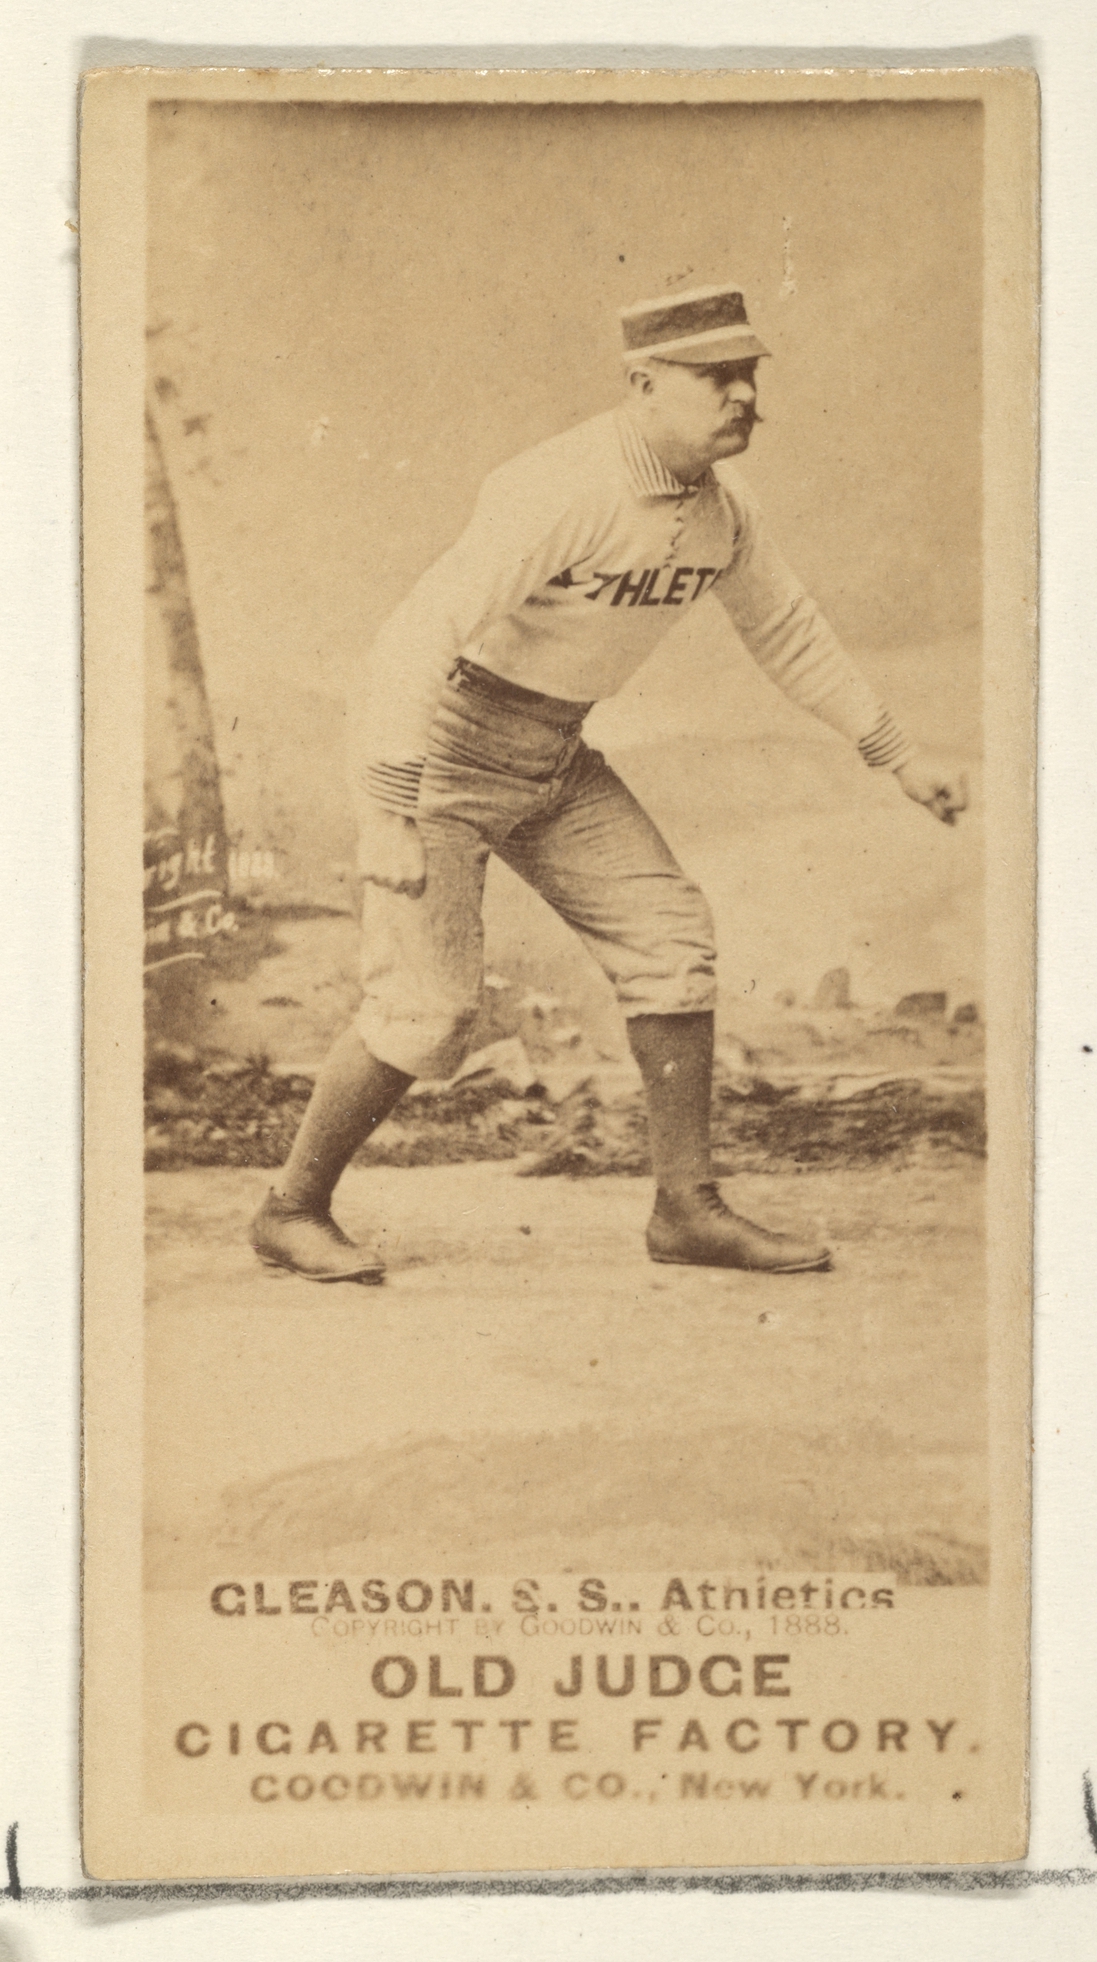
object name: baseball card, photograph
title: Gleason, Shortstop, Philadelphia Athletics, from the Old Judge series (N172) for Old Judge Cigarettes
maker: goodwin & company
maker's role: publisher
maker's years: 1850-1950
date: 1888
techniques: albumen silver print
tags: men,portraits,baseball,athletes